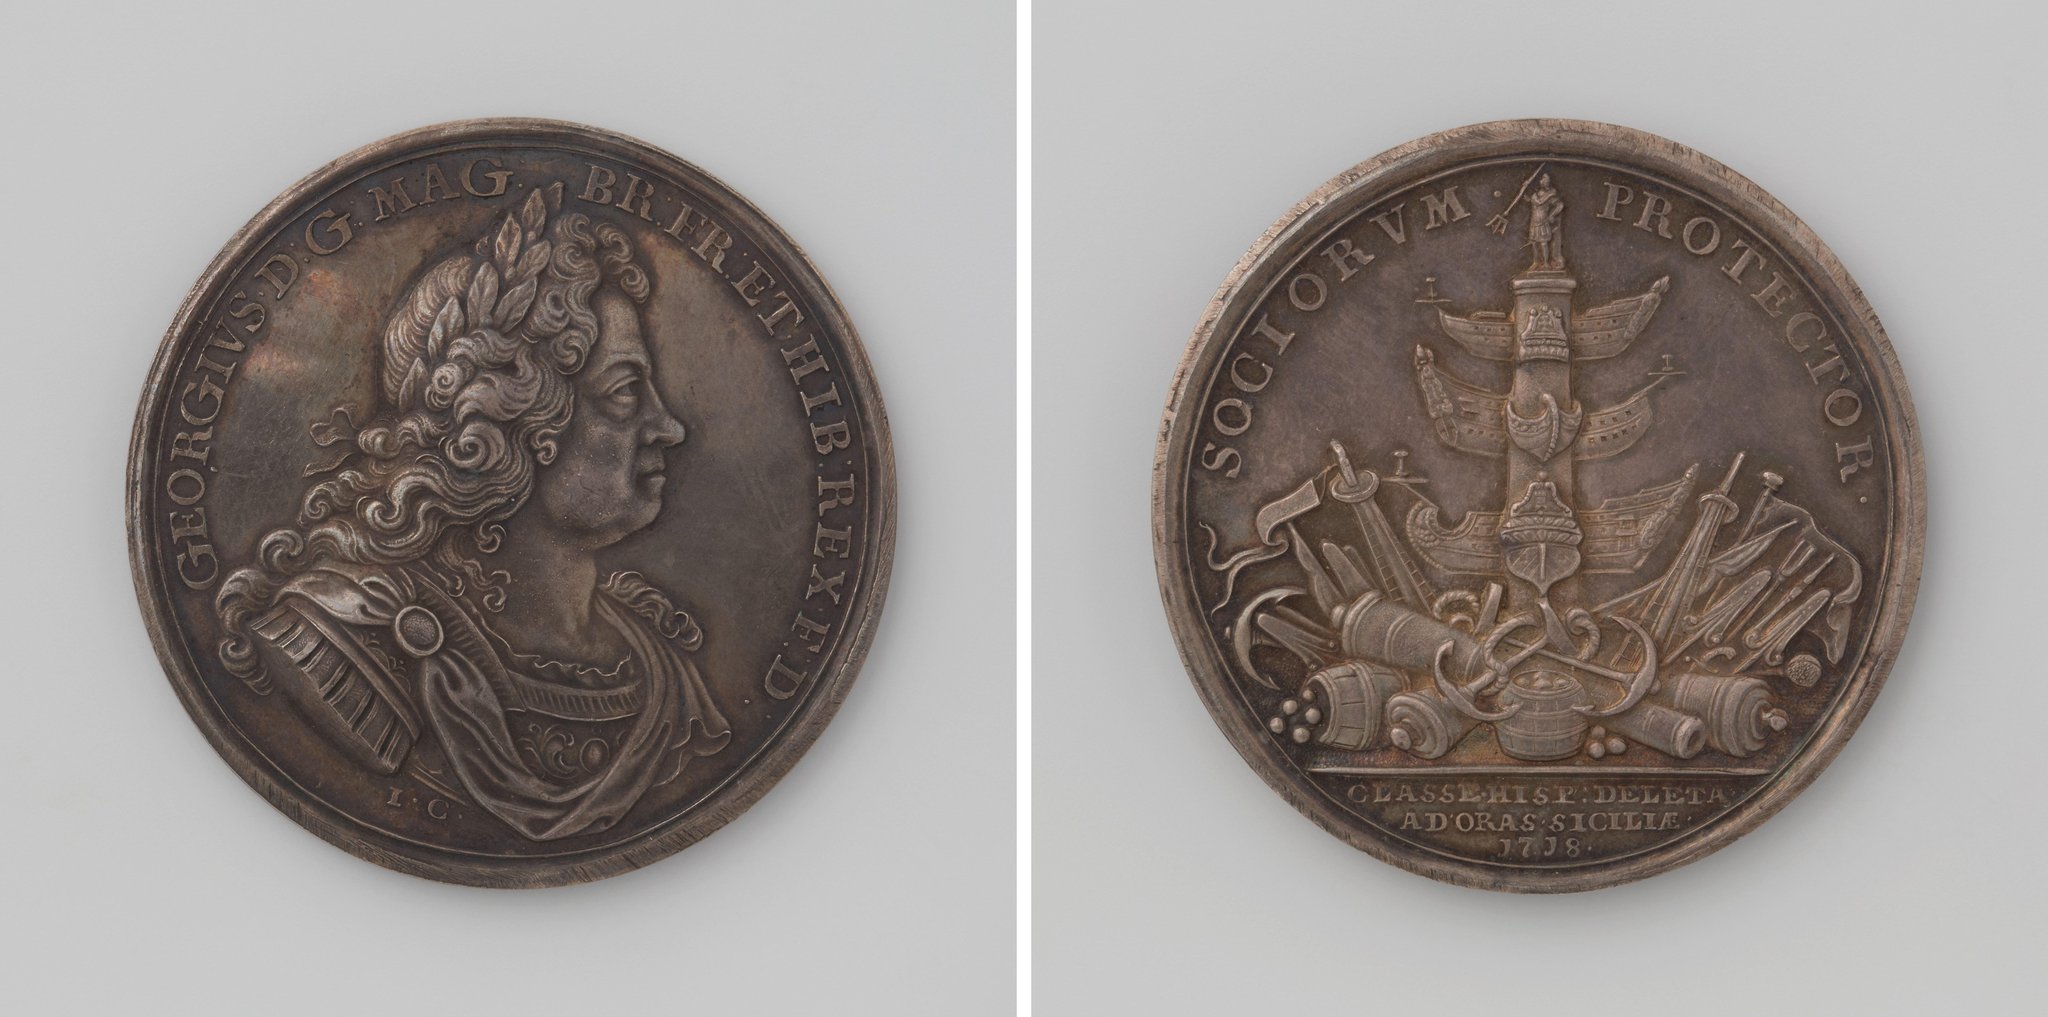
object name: history medal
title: Verslaan van de Spaanse vloot bij kaap Passaro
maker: john croker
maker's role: die cutter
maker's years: 1670-1741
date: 1718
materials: silver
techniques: striking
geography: london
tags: george i (koning van groot-brittannië en ierland)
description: Zilveren penning. Voorzijde: borststuk man met lauwerkrans binnen omschrift. Keerzijde: zuil met scheepsstevens bekroond door Overwinningsbeeld temidden van allerhande scheepswapens binnen omschrift; afsnede: opschrift